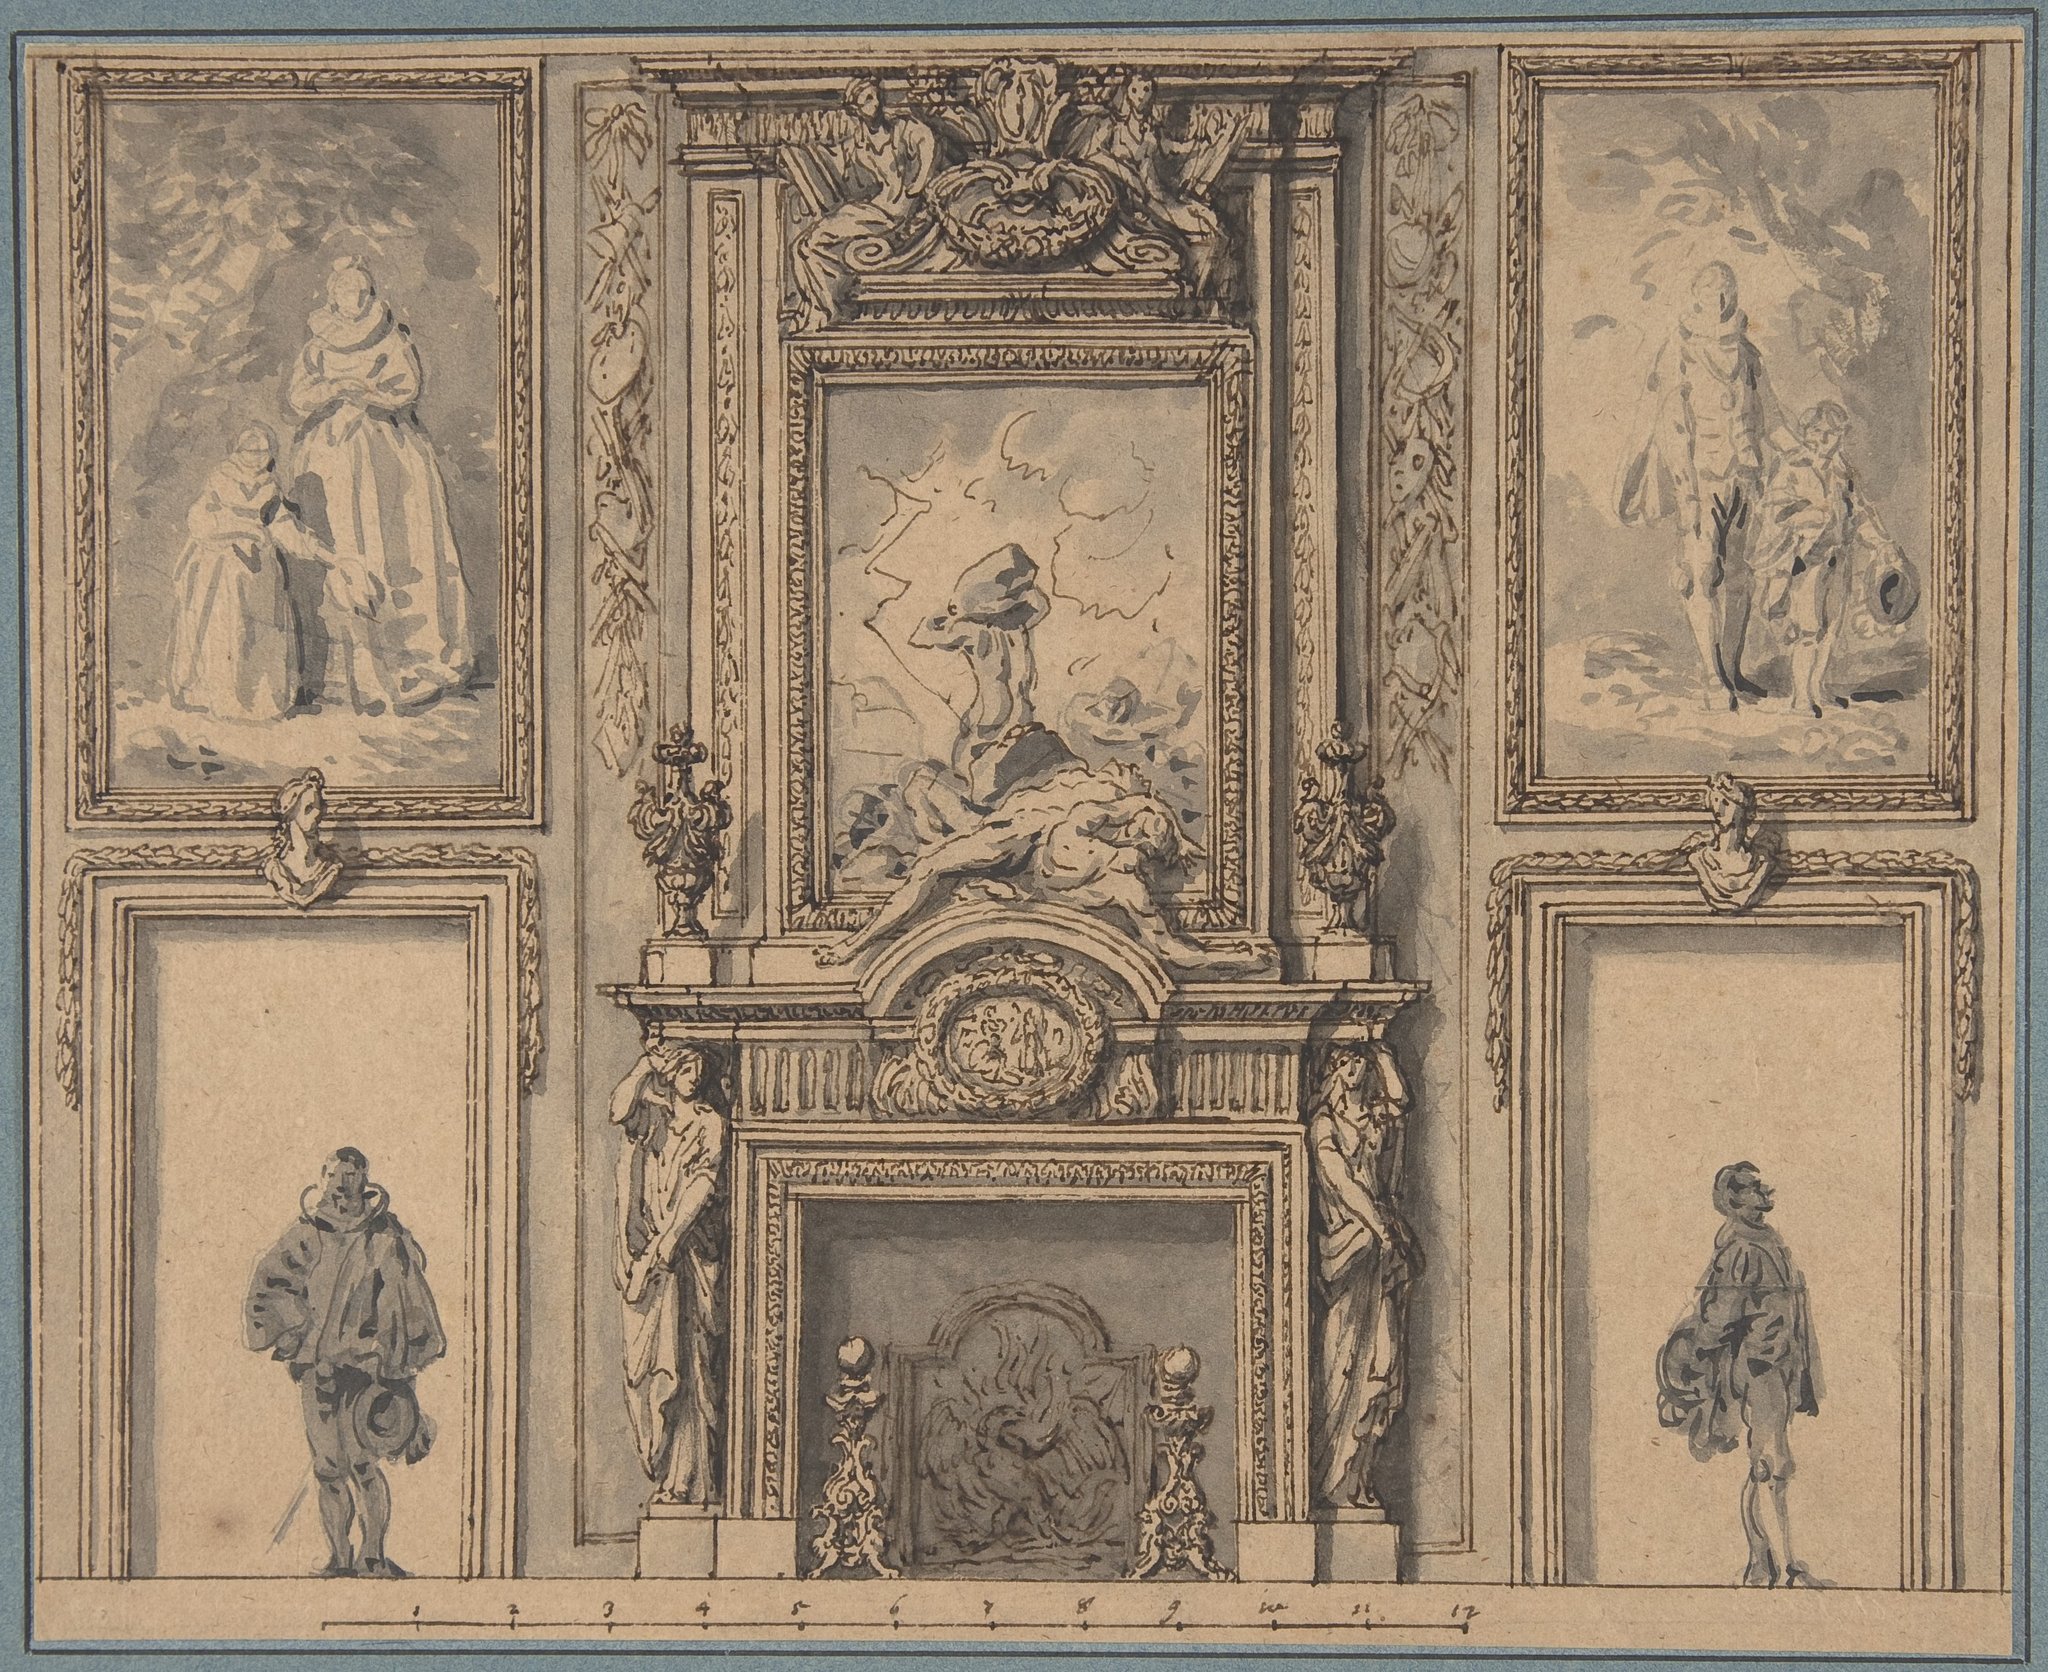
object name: drawing ornament architecture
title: Design for a Wall Decoration with Chimneypiece and Two Figures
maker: antoine le pautre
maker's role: artist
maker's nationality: french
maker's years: 1621-1679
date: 1650-1670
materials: ink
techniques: brush, pen, wash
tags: fireplaces,men,women